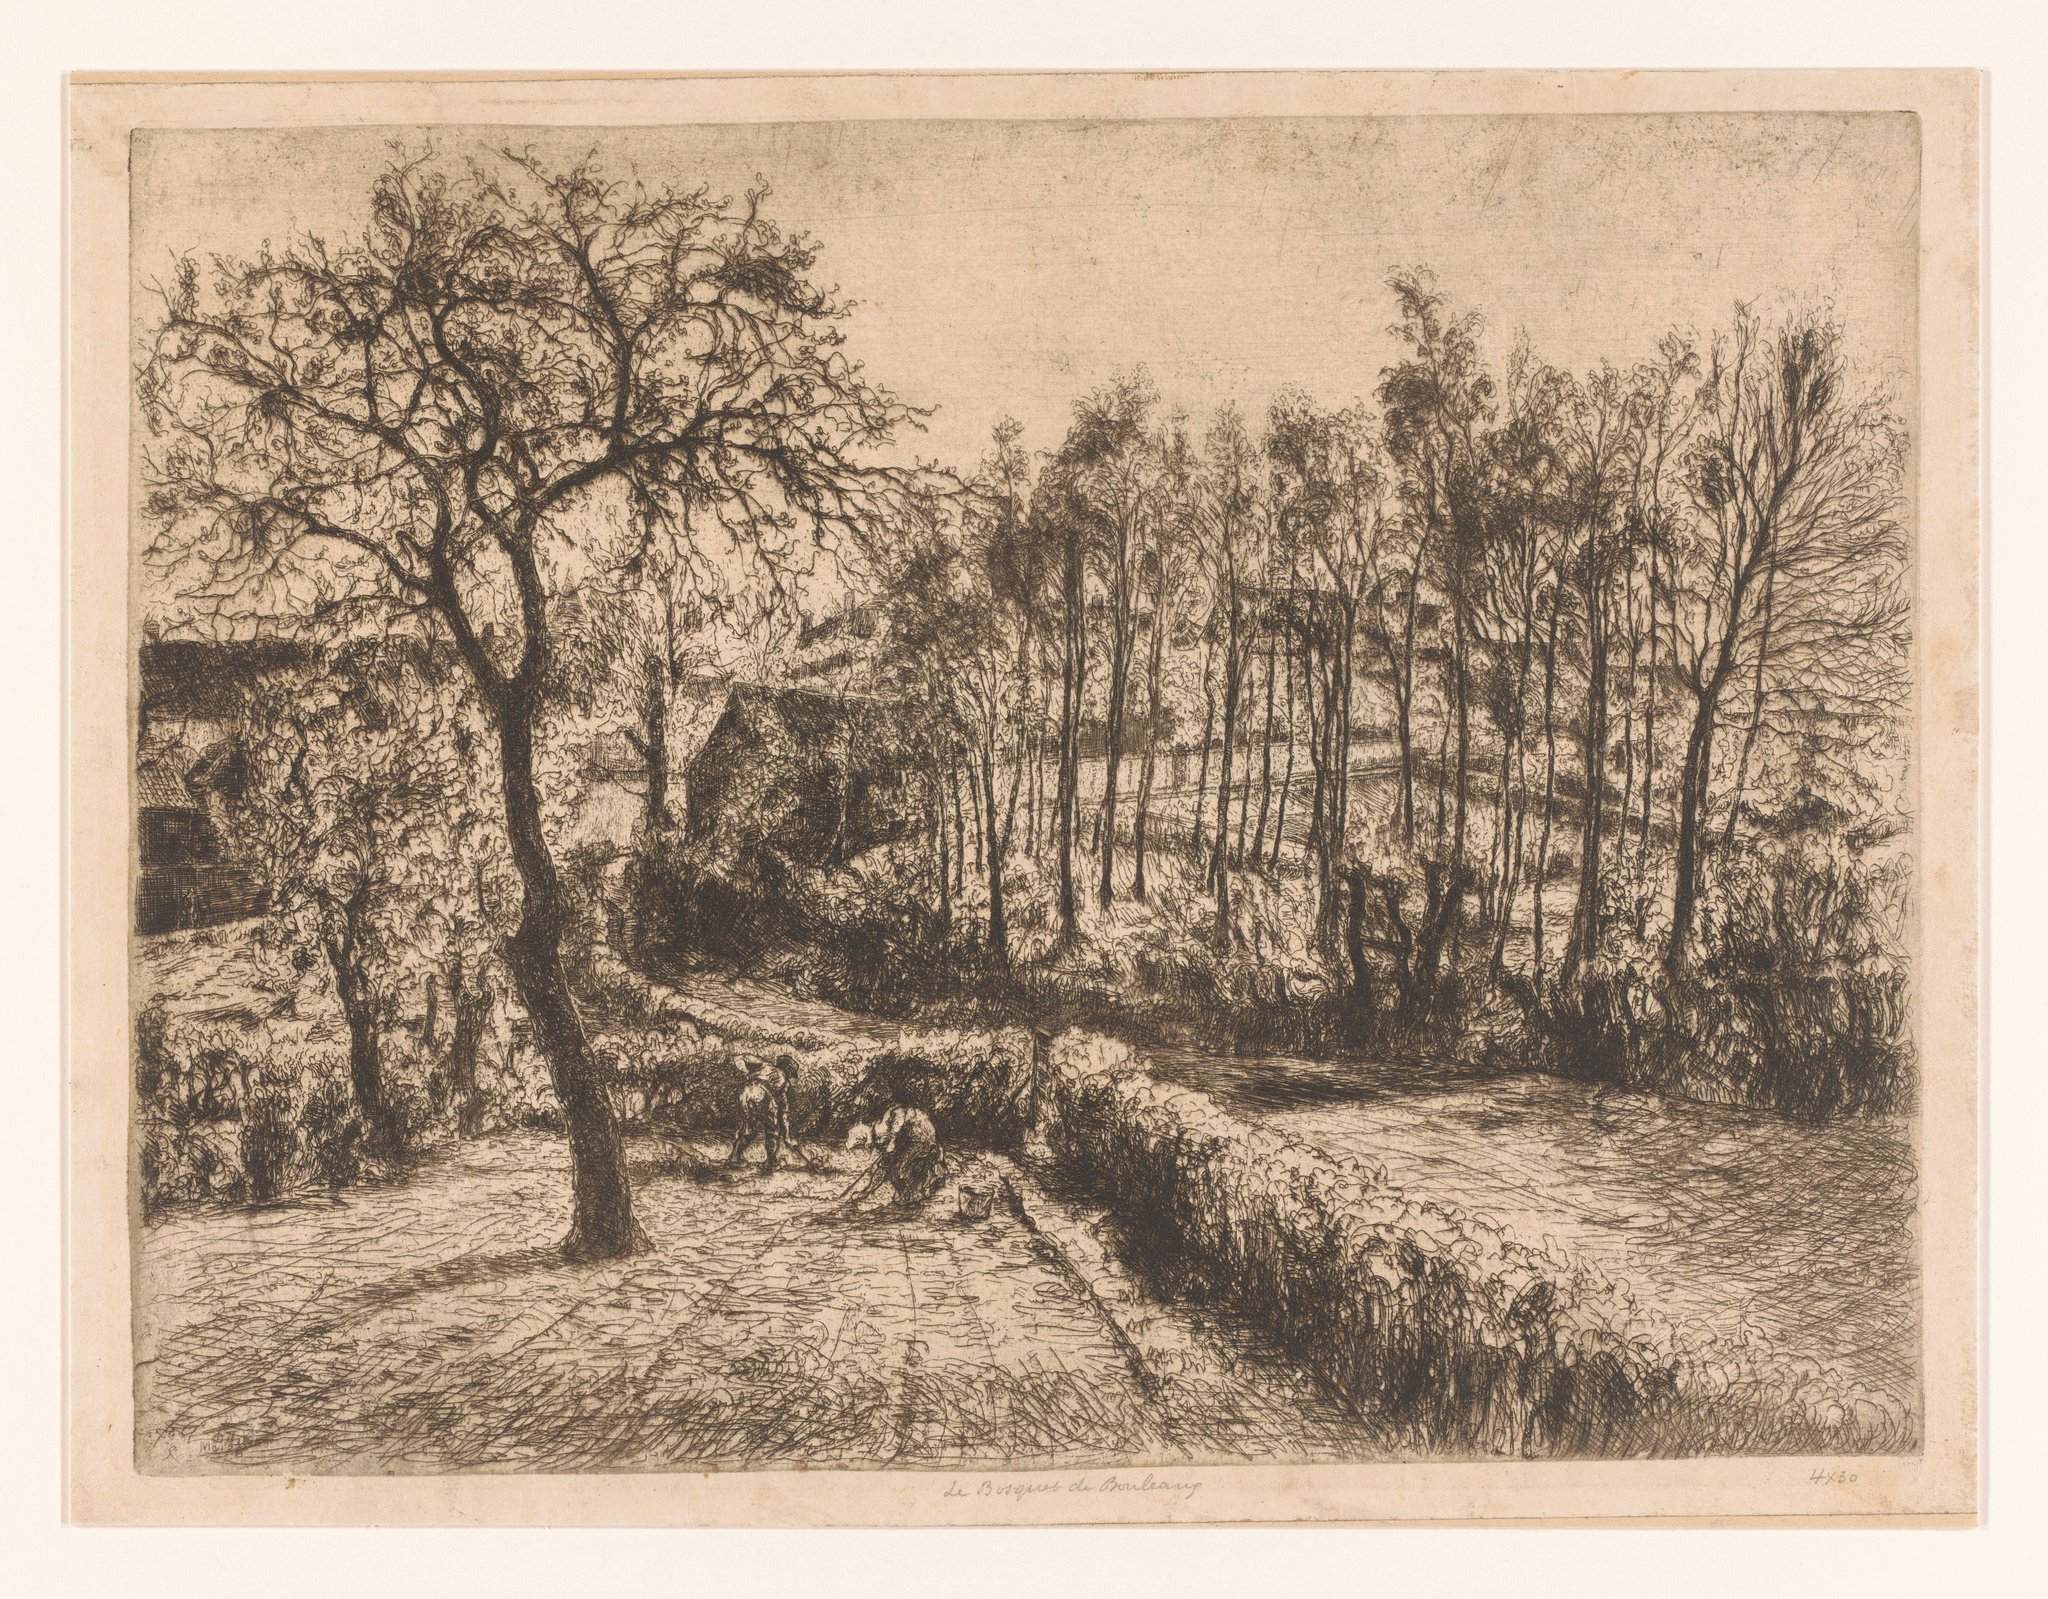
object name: print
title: Man en vrouw bewerken de grond in een landschap met omheinde kavels en bomen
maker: albert delstanche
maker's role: print maker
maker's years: 1870-1941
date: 1880-1940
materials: paper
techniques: etching, intaglio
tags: trees, fenced or walled garden; 'hortus conclusus'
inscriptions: inscription: ‘Le Bosquet de Bouleaux’, inscription: ‘Albert Delstanche Brabantsch landschap belgique [...] Ohain’, collector's mark: Lugt 2760, collector's mark: Lugt 2228